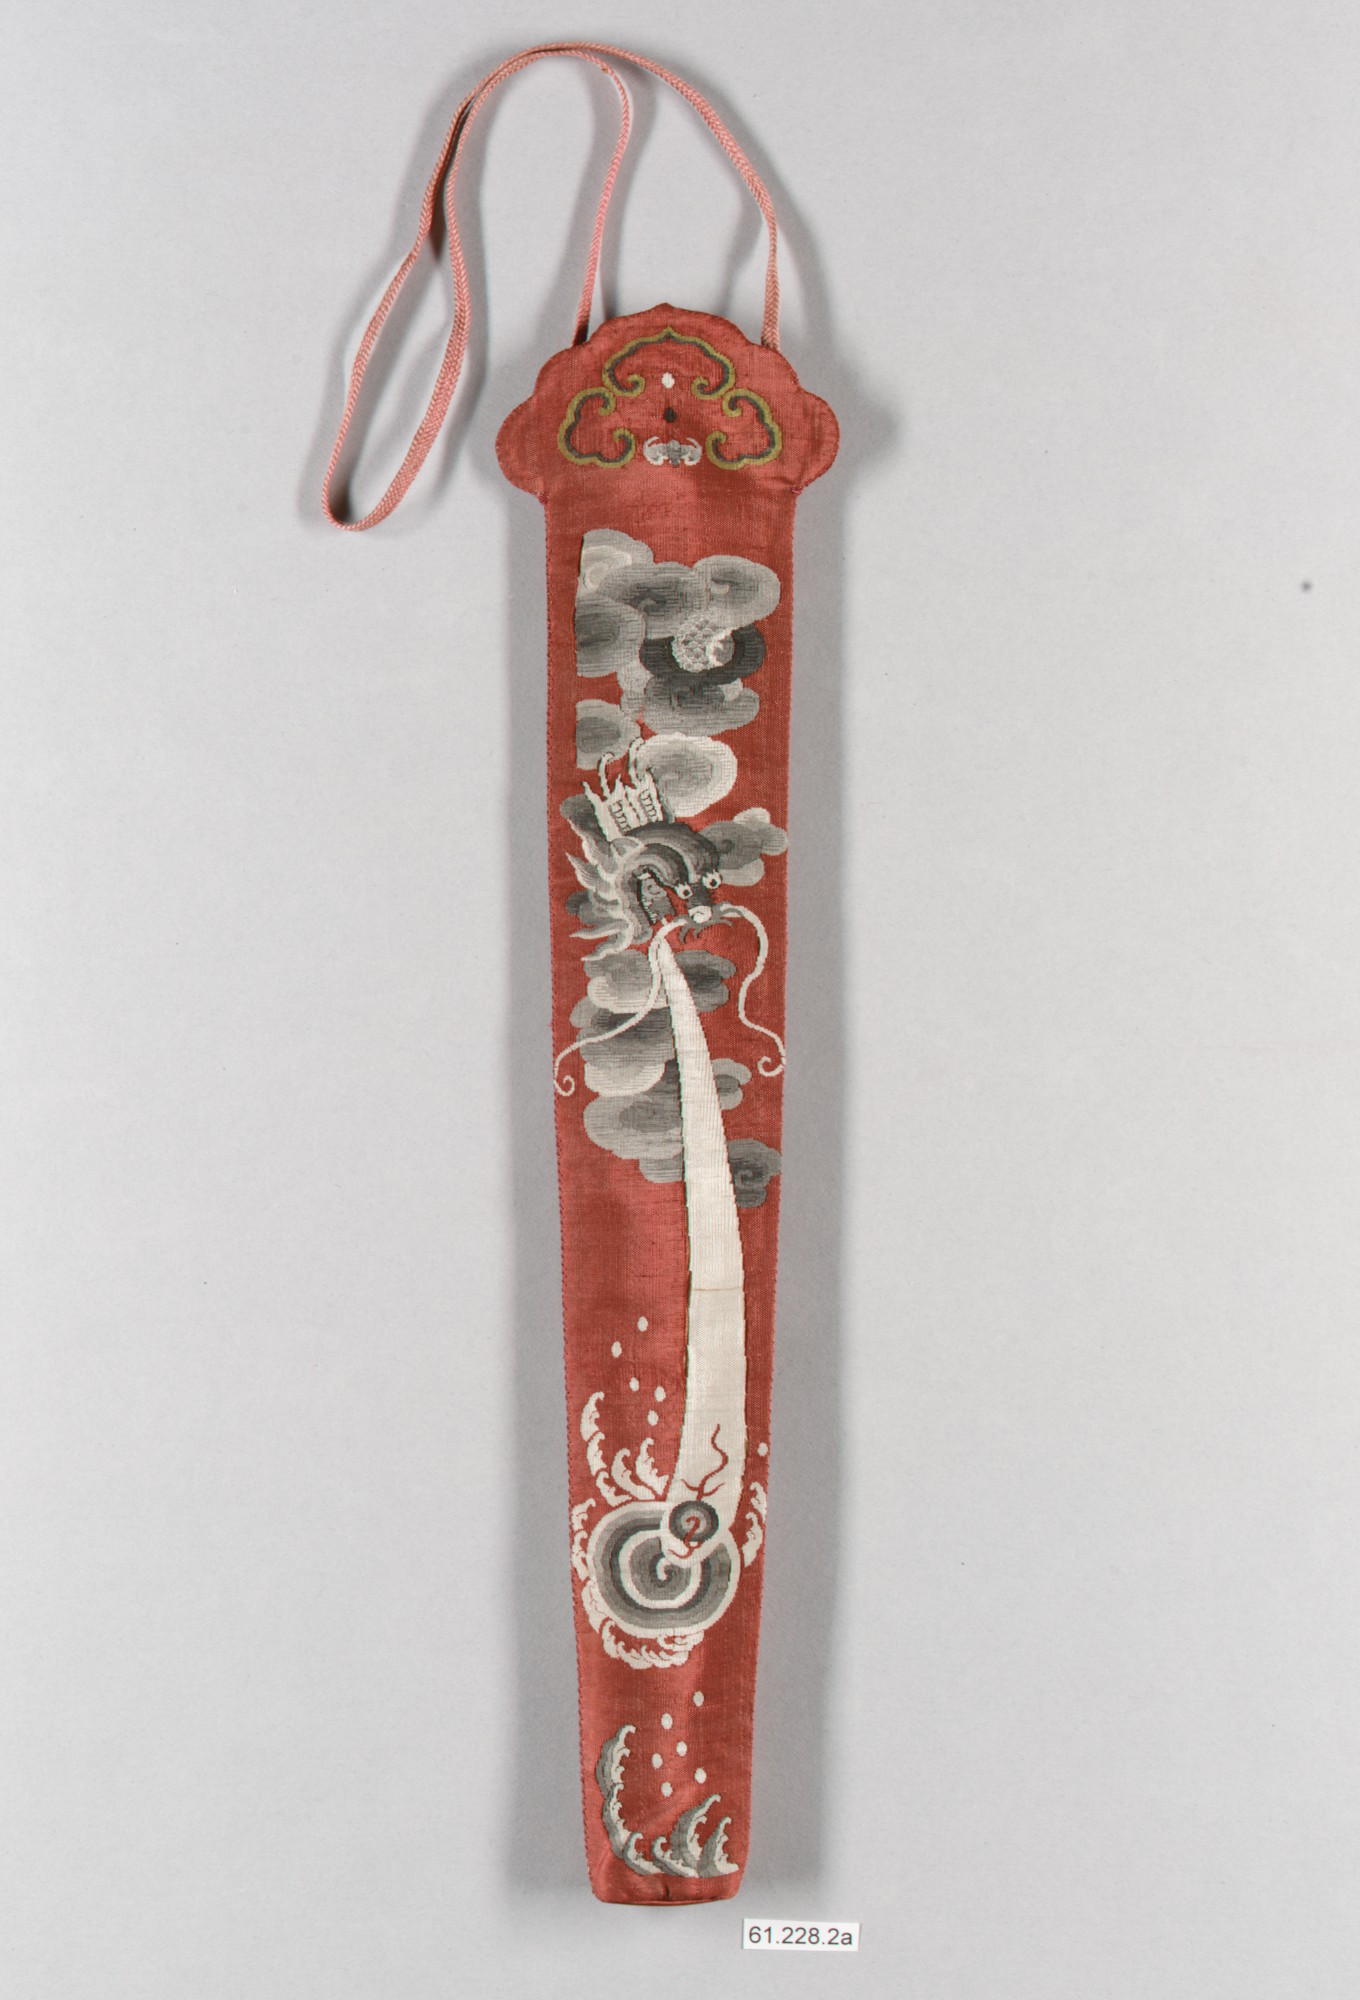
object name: girdle set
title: Girdle Set with Dragon, Clouds and Waves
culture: chinese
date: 1701-1900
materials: silk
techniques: tapestry, weave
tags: dragons